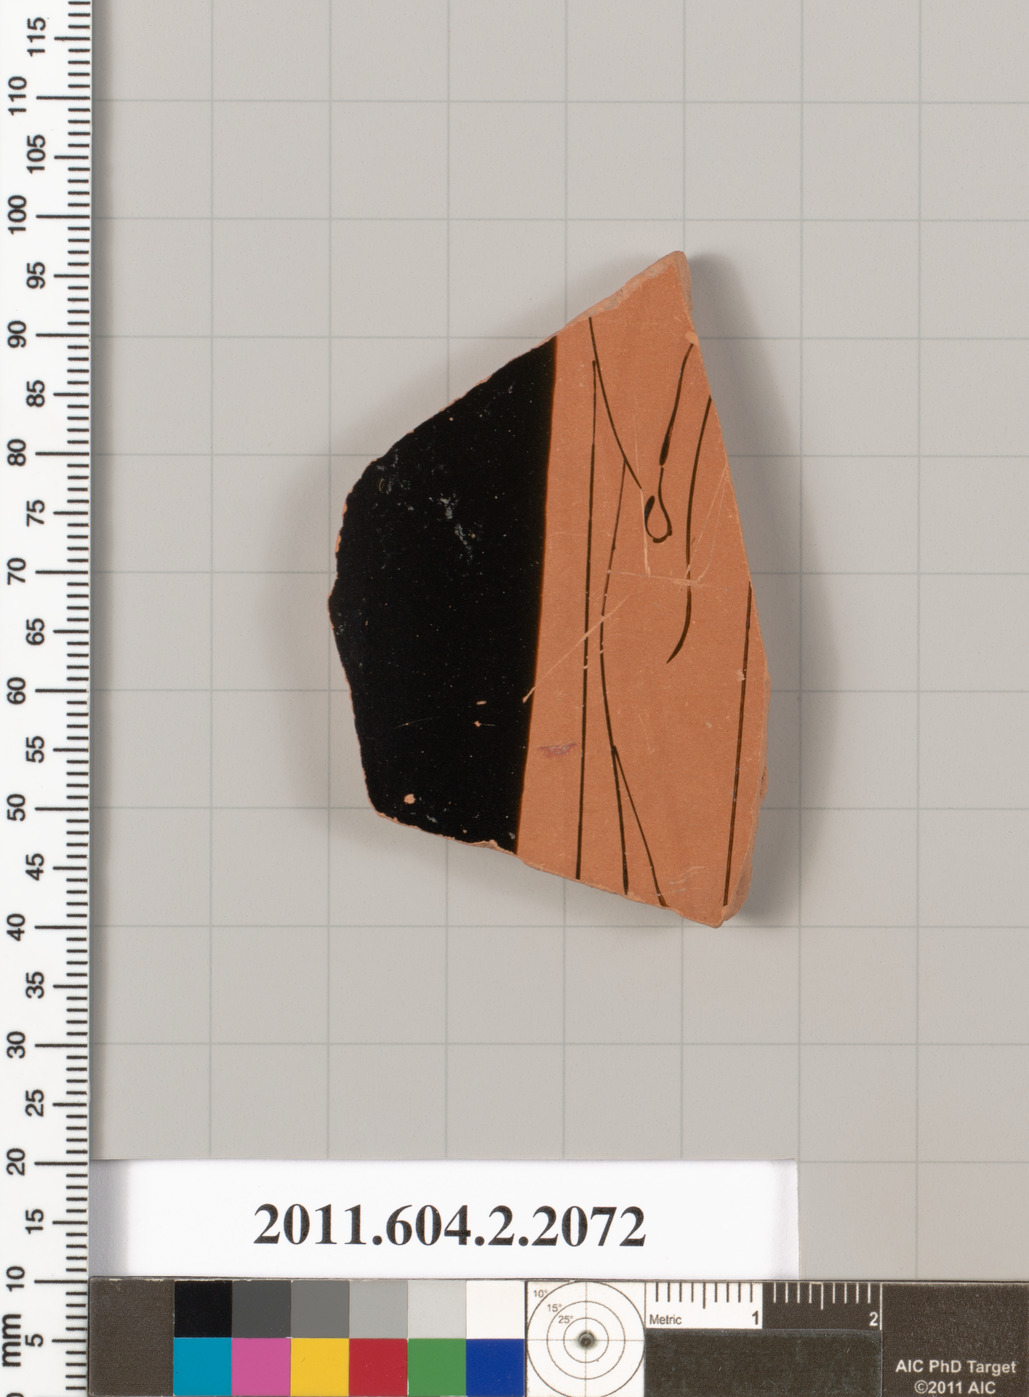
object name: pot fragment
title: Terracotta fragment of a pot; glazed on the inside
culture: greek, attic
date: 460-440 BCE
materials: terracotta